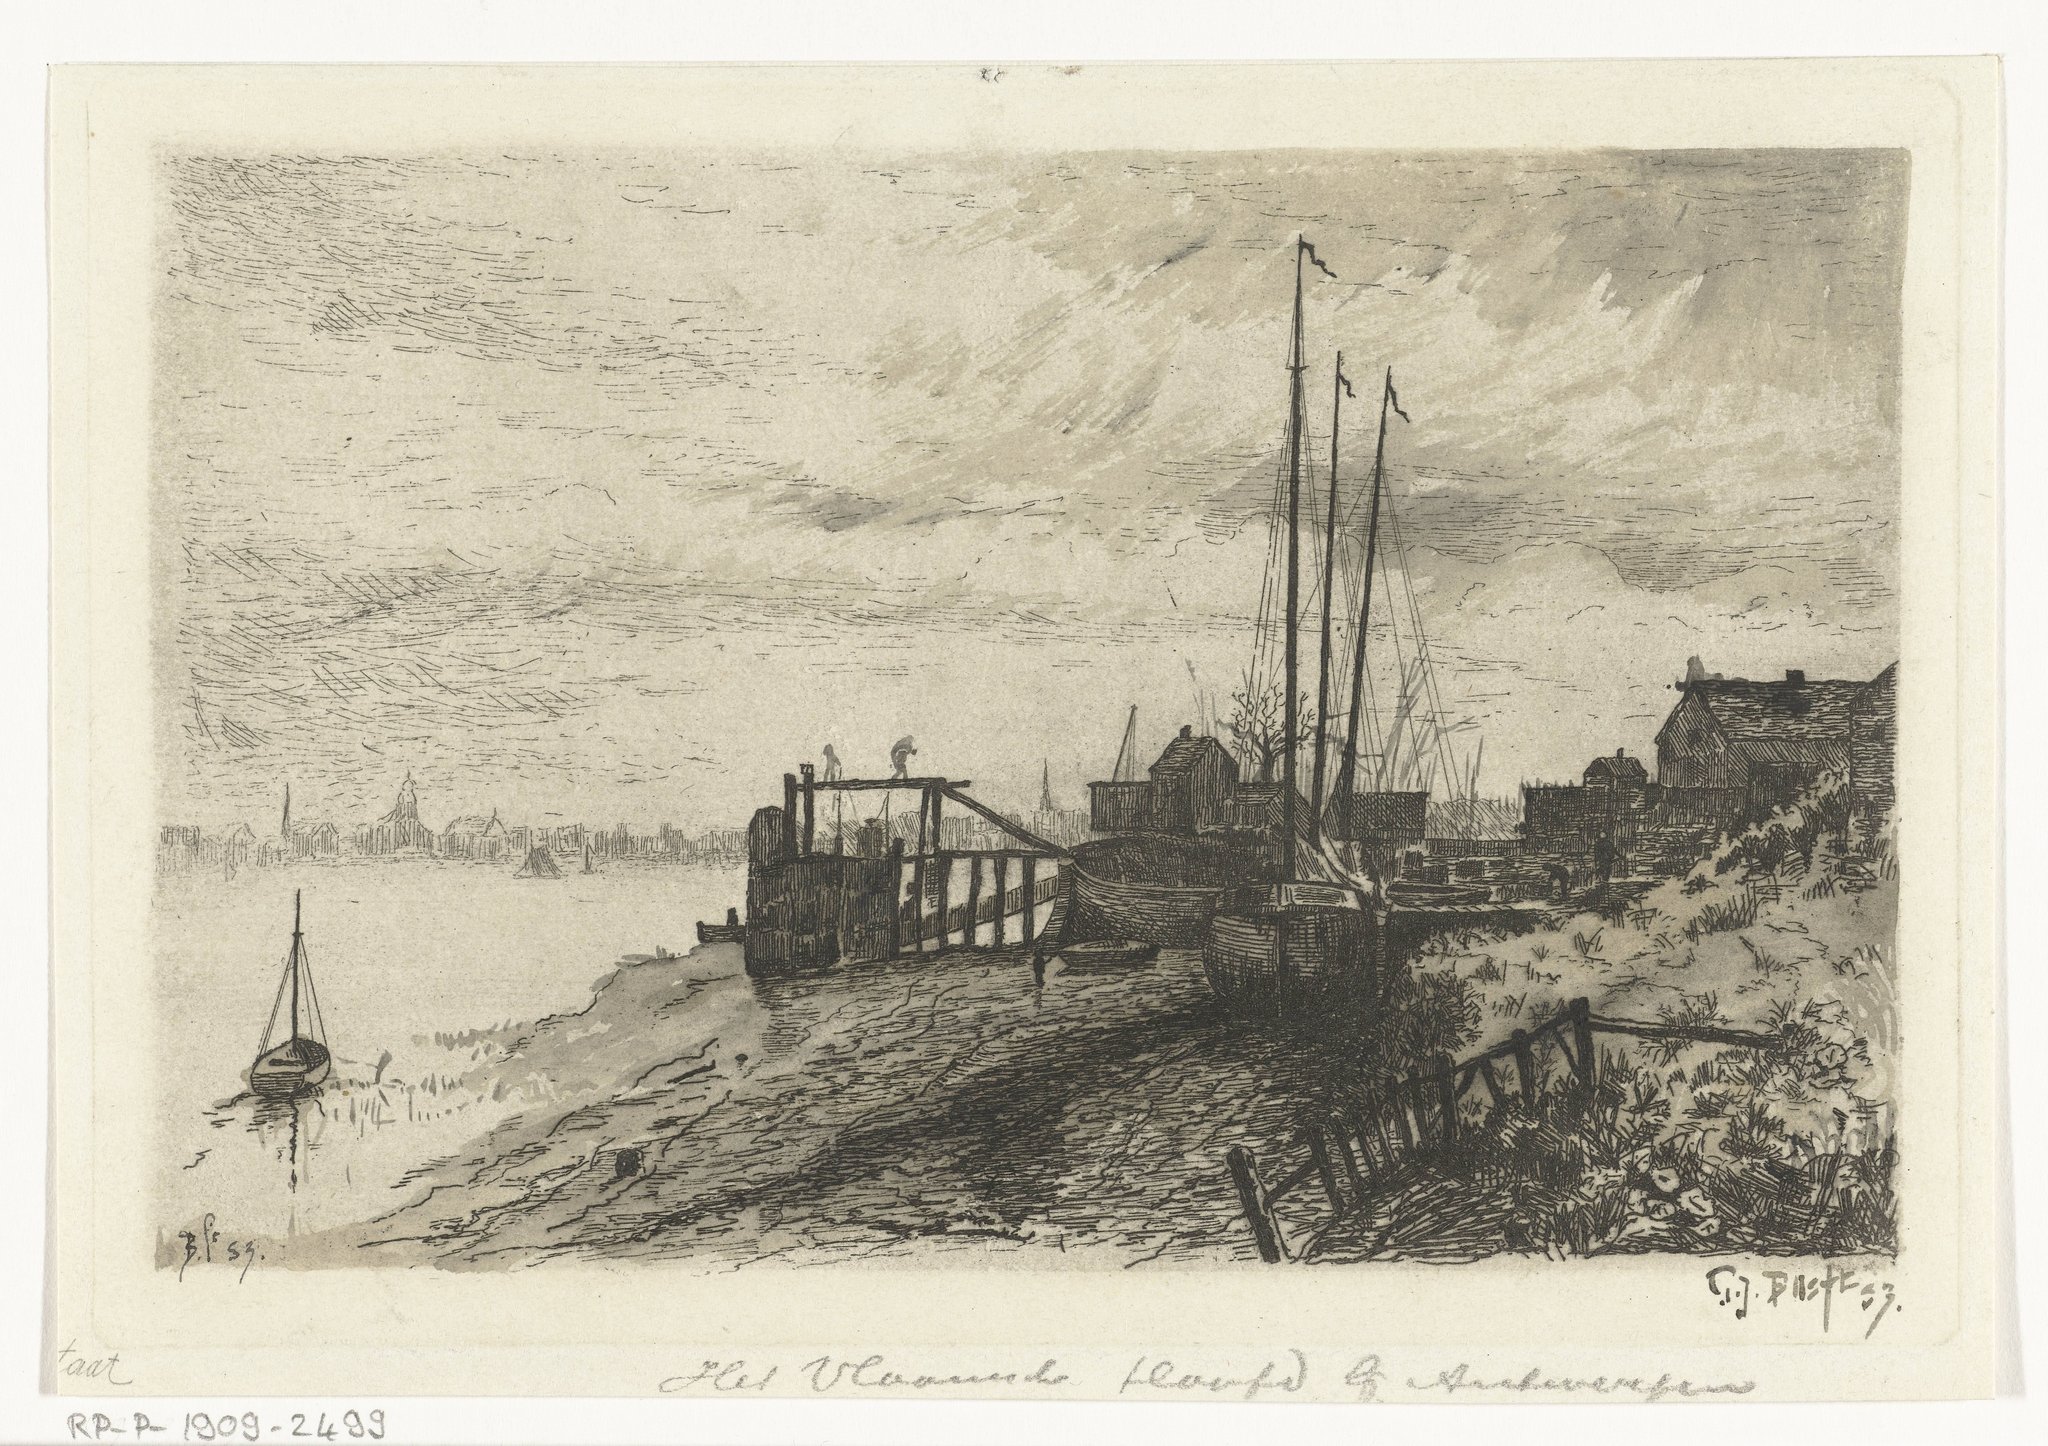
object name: print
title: Het Vlaamsche Hoofd bij Antwerpen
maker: gerard jan bos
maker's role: print maker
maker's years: 1860-1943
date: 1883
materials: paper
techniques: aquatint, brush, etching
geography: antwerp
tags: river bank, antwerp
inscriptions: inscription: ‘Het Vlaamsche Hoofd bij Antwerpen’, collector's mark: Lugt 2228